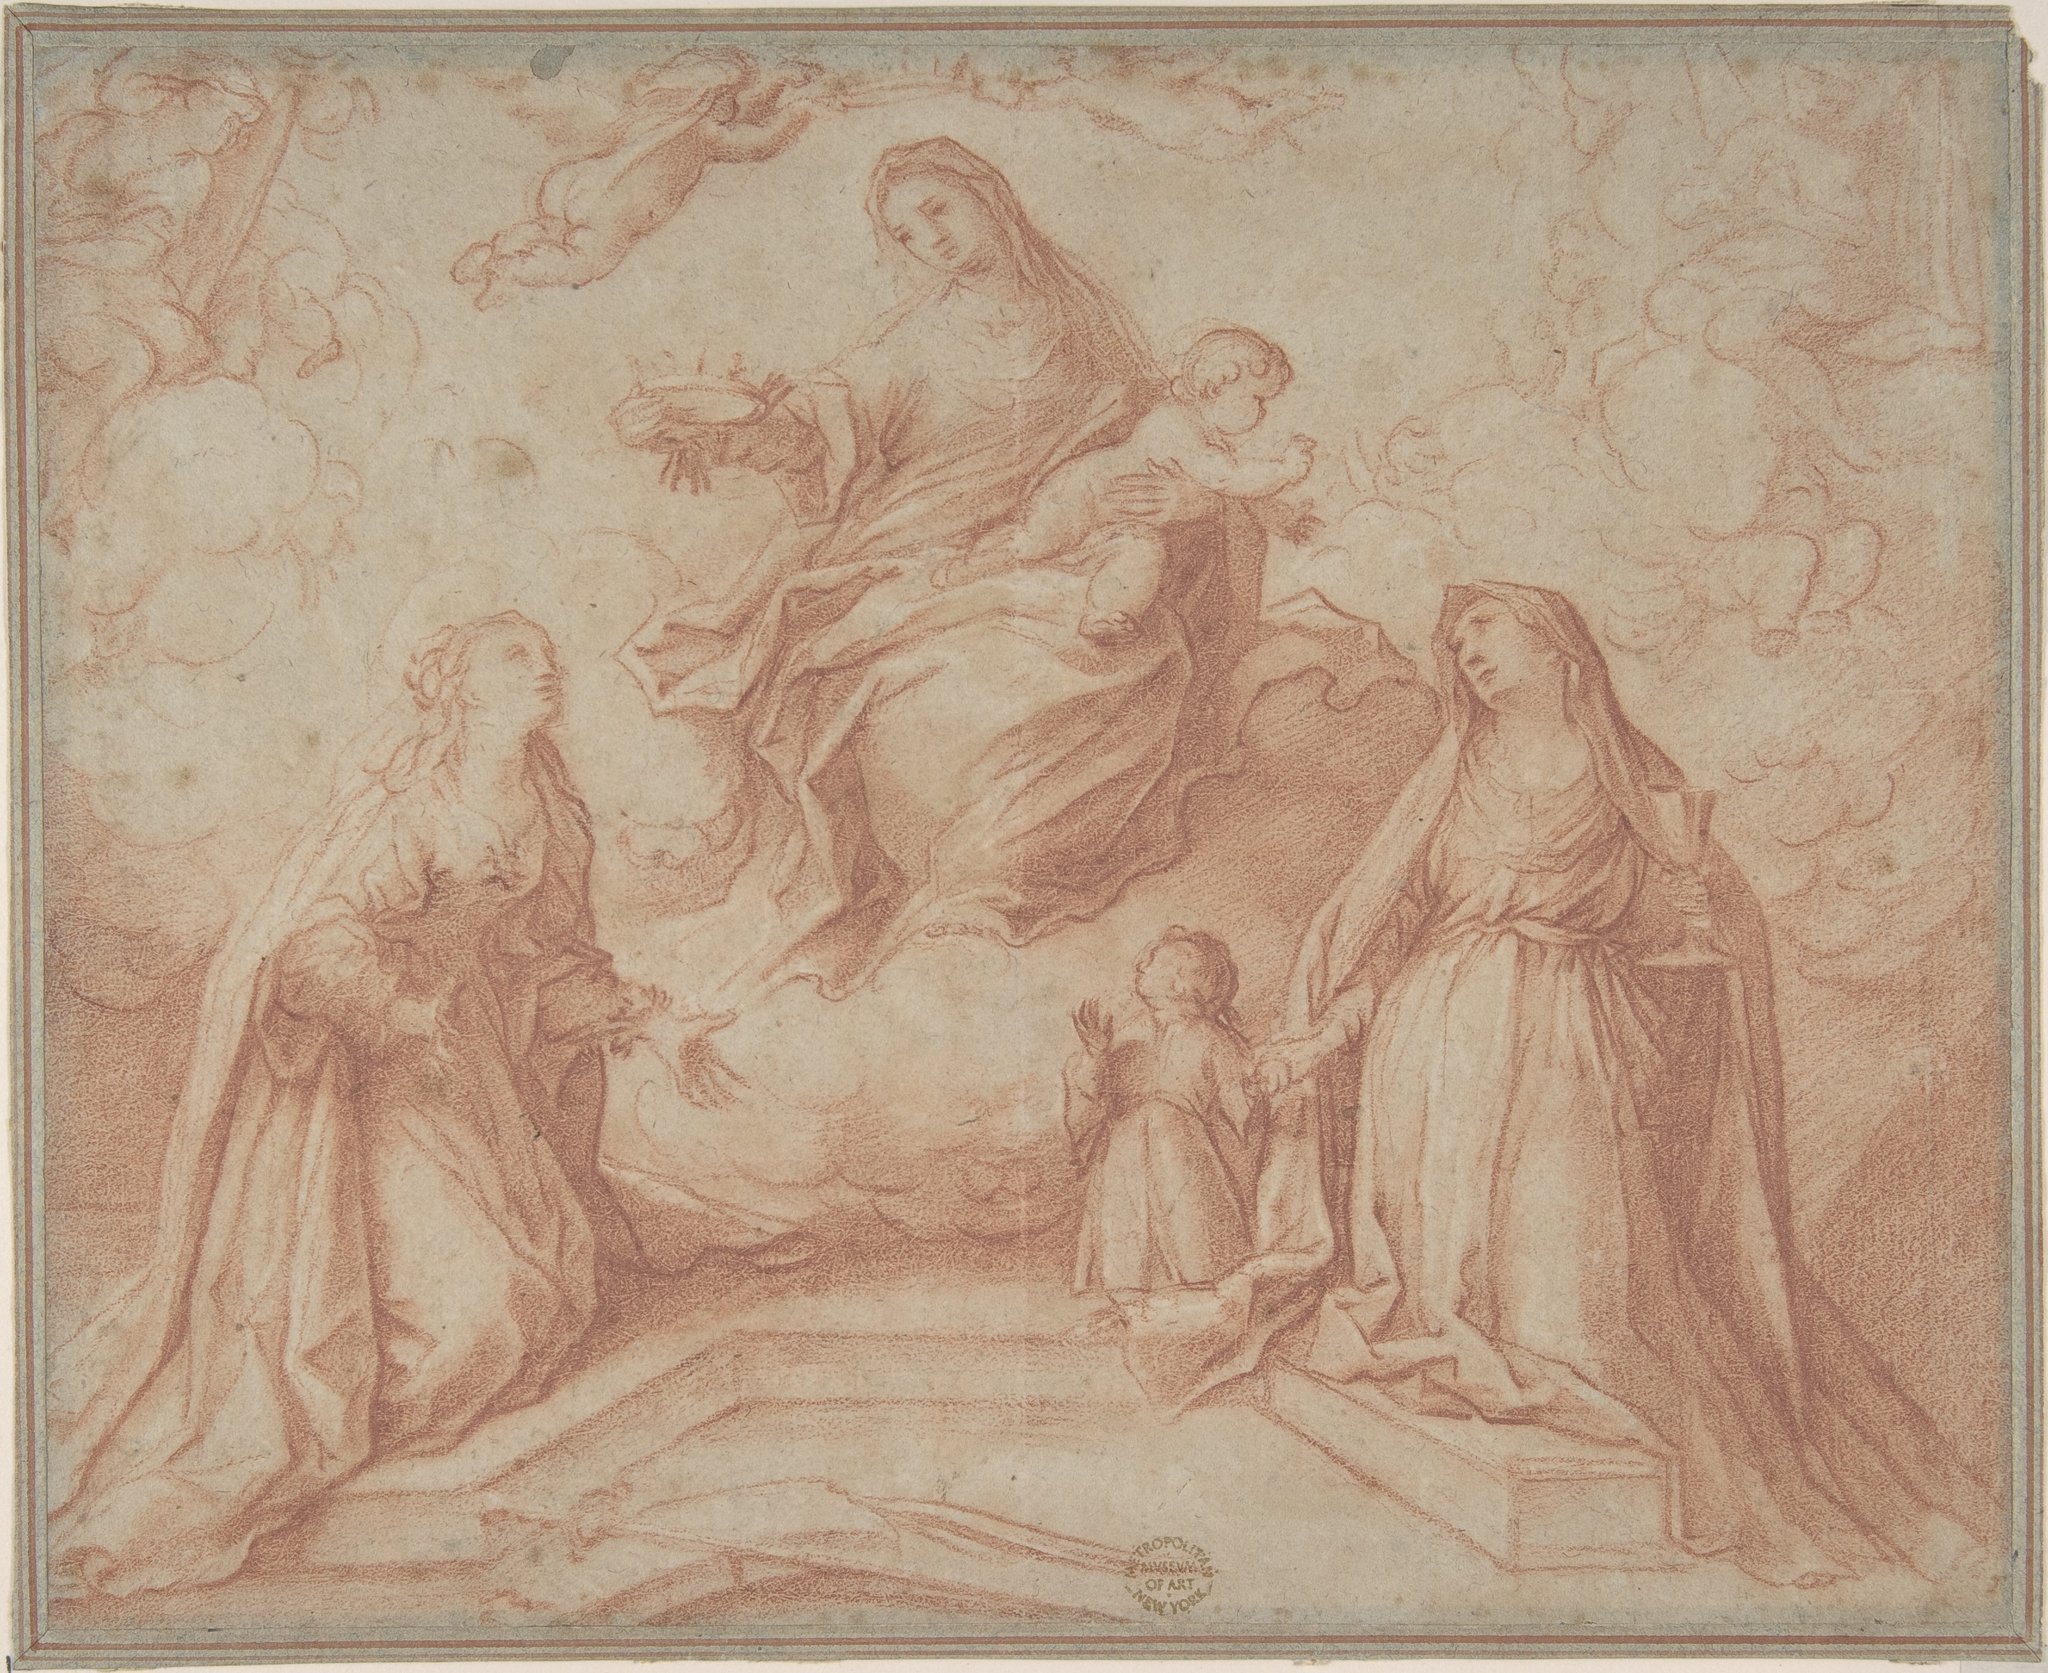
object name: drawing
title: Madonna and Child with Saints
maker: anonymous, italian, roman-bolognese, 17th century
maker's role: artist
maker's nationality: italian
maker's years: 1600-1700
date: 1601-1700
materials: chalk, paper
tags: putti,madonna and child,saints